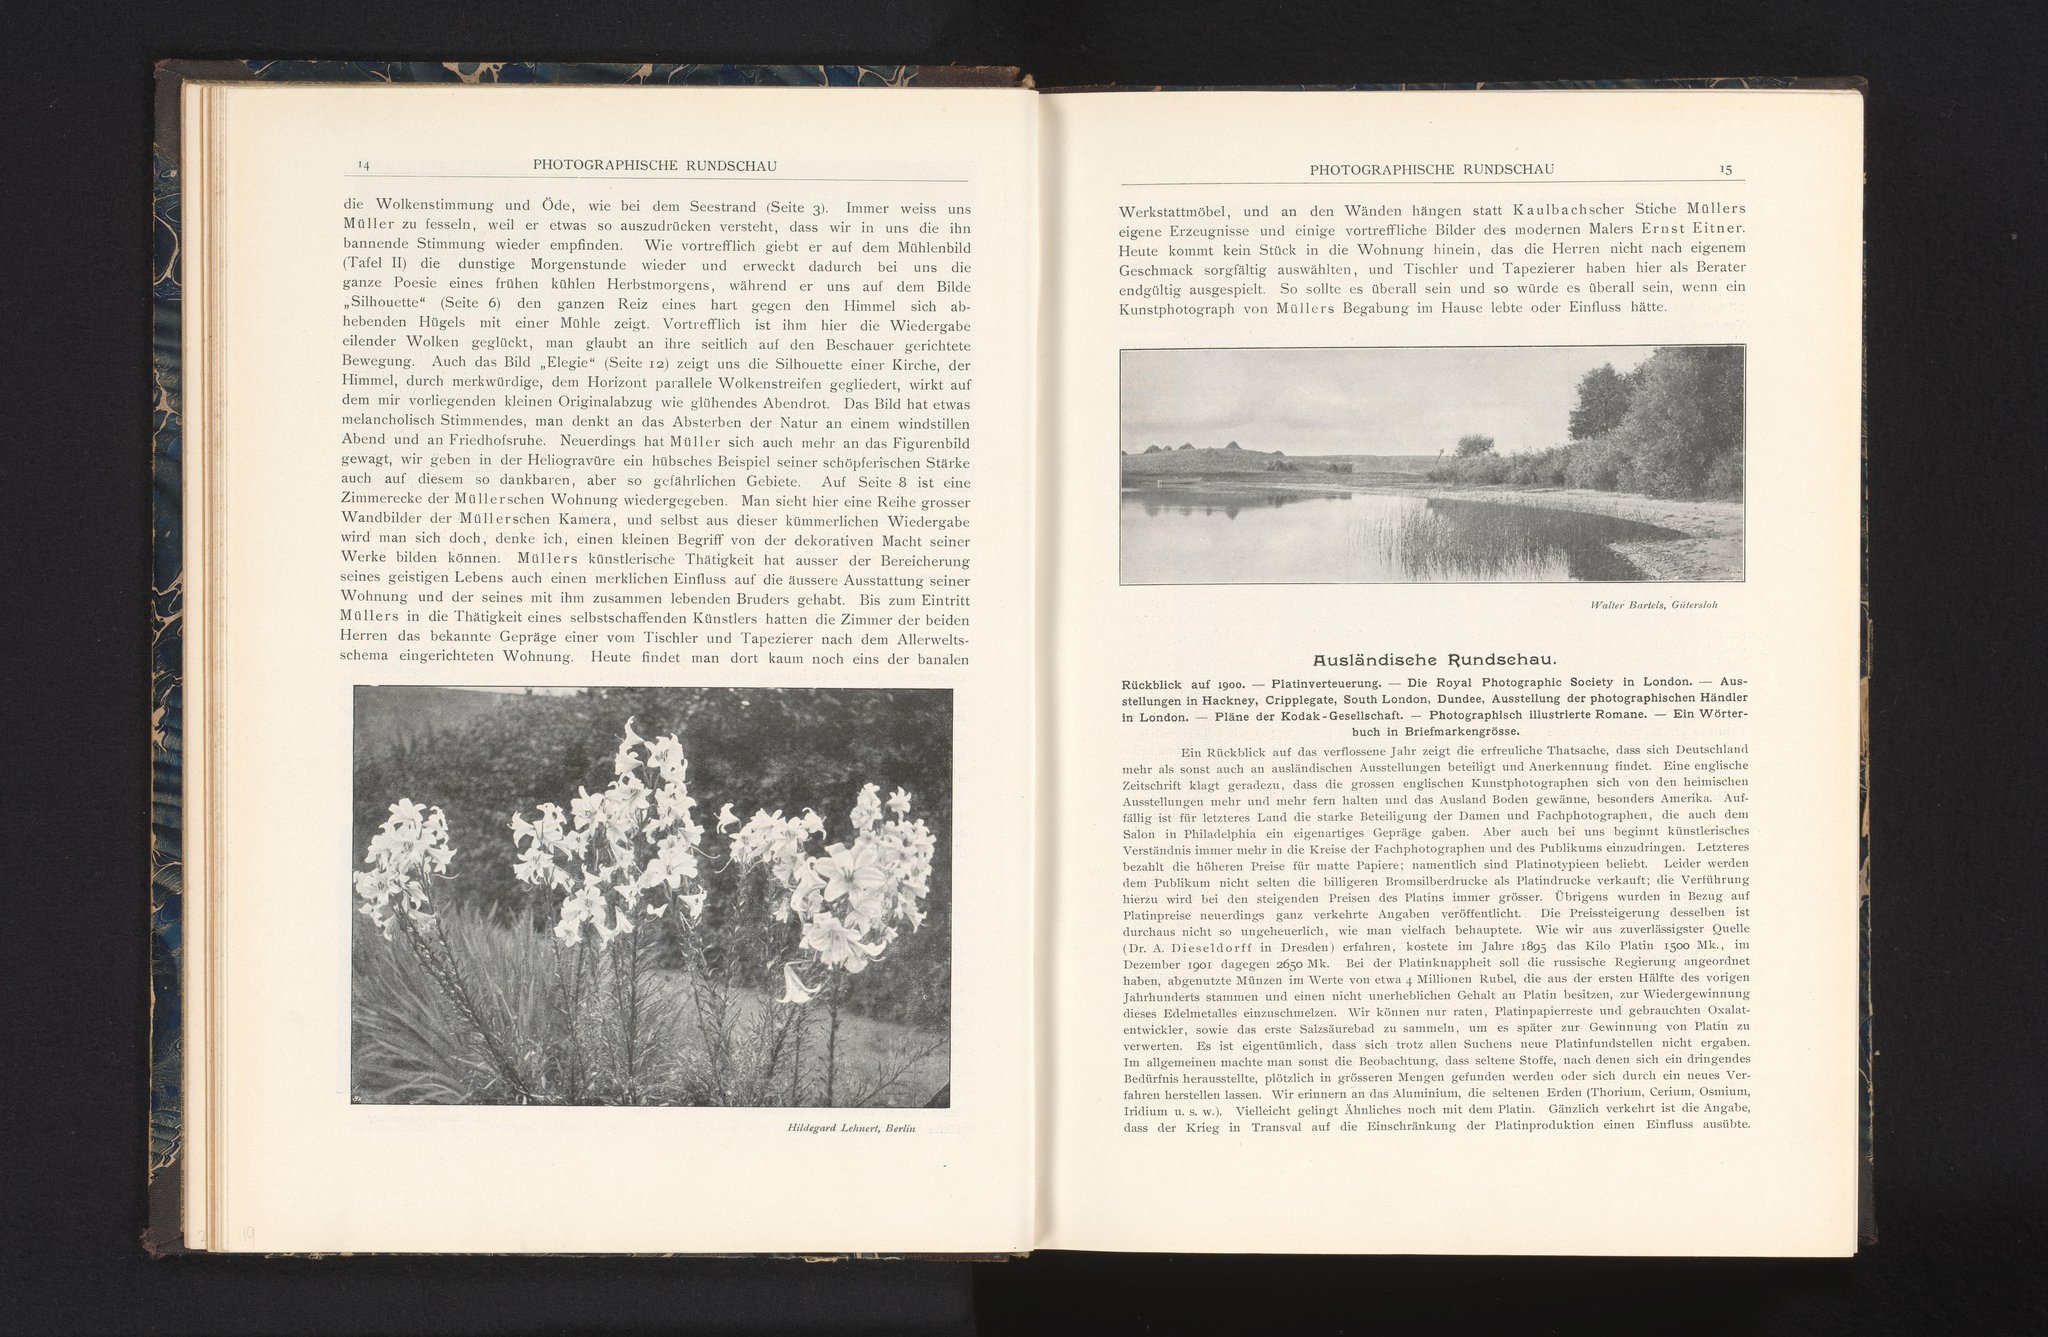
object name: photomechanical print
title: Gezicht op bloemen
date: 1897-1902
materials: paper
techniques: autotype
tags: flowers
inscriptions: monogram: ‘BX’